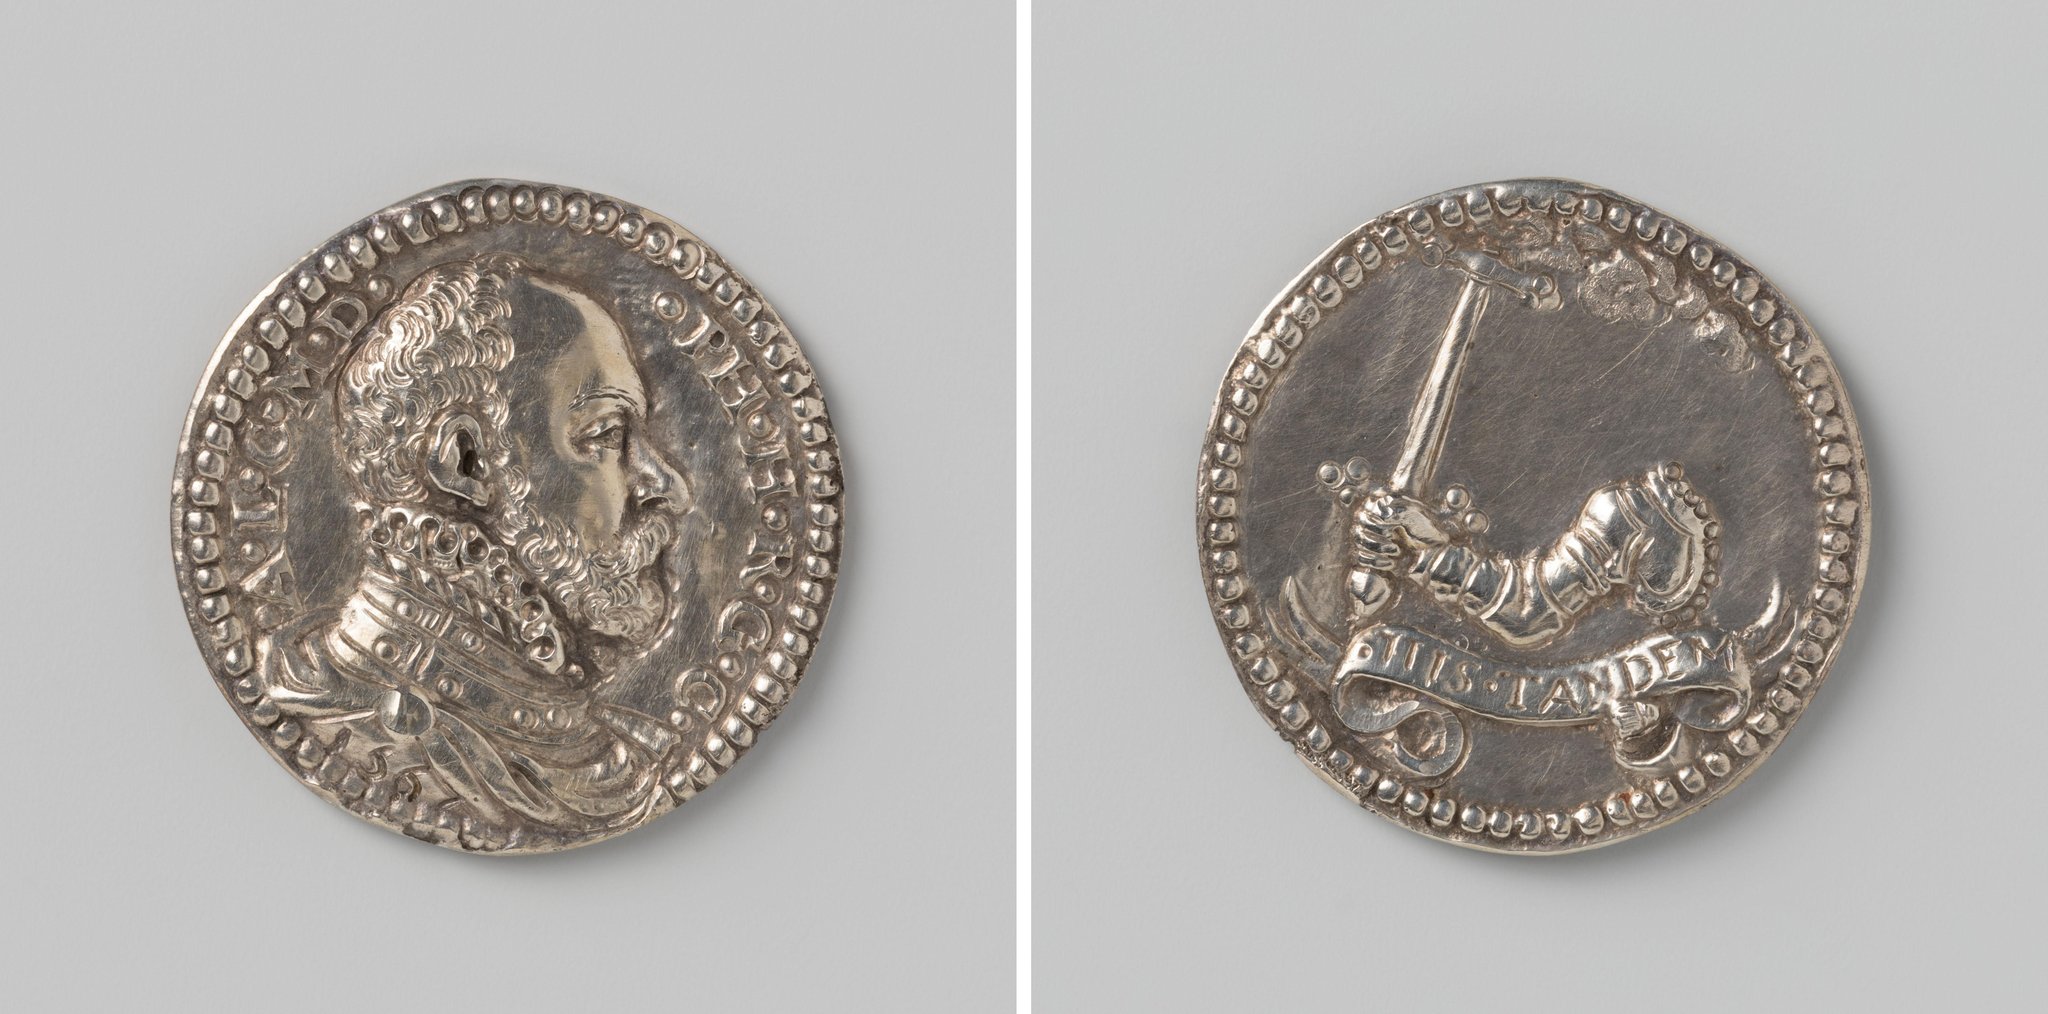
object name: jeton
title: Alberik, graaf van Lodron, generaal van Karel V en Filips II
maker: jacques jonghelinck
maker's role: medailleur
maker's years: 1530-1606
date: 1567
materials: silver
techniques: casting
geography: antwerp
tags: alberik graaf van lodron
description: Zilveren penning. Voorzijde: borststuk man binnen omschrift. Keerzijde: arm met zwaard, uitlopend in een kruis boven wimpel met opschrift.